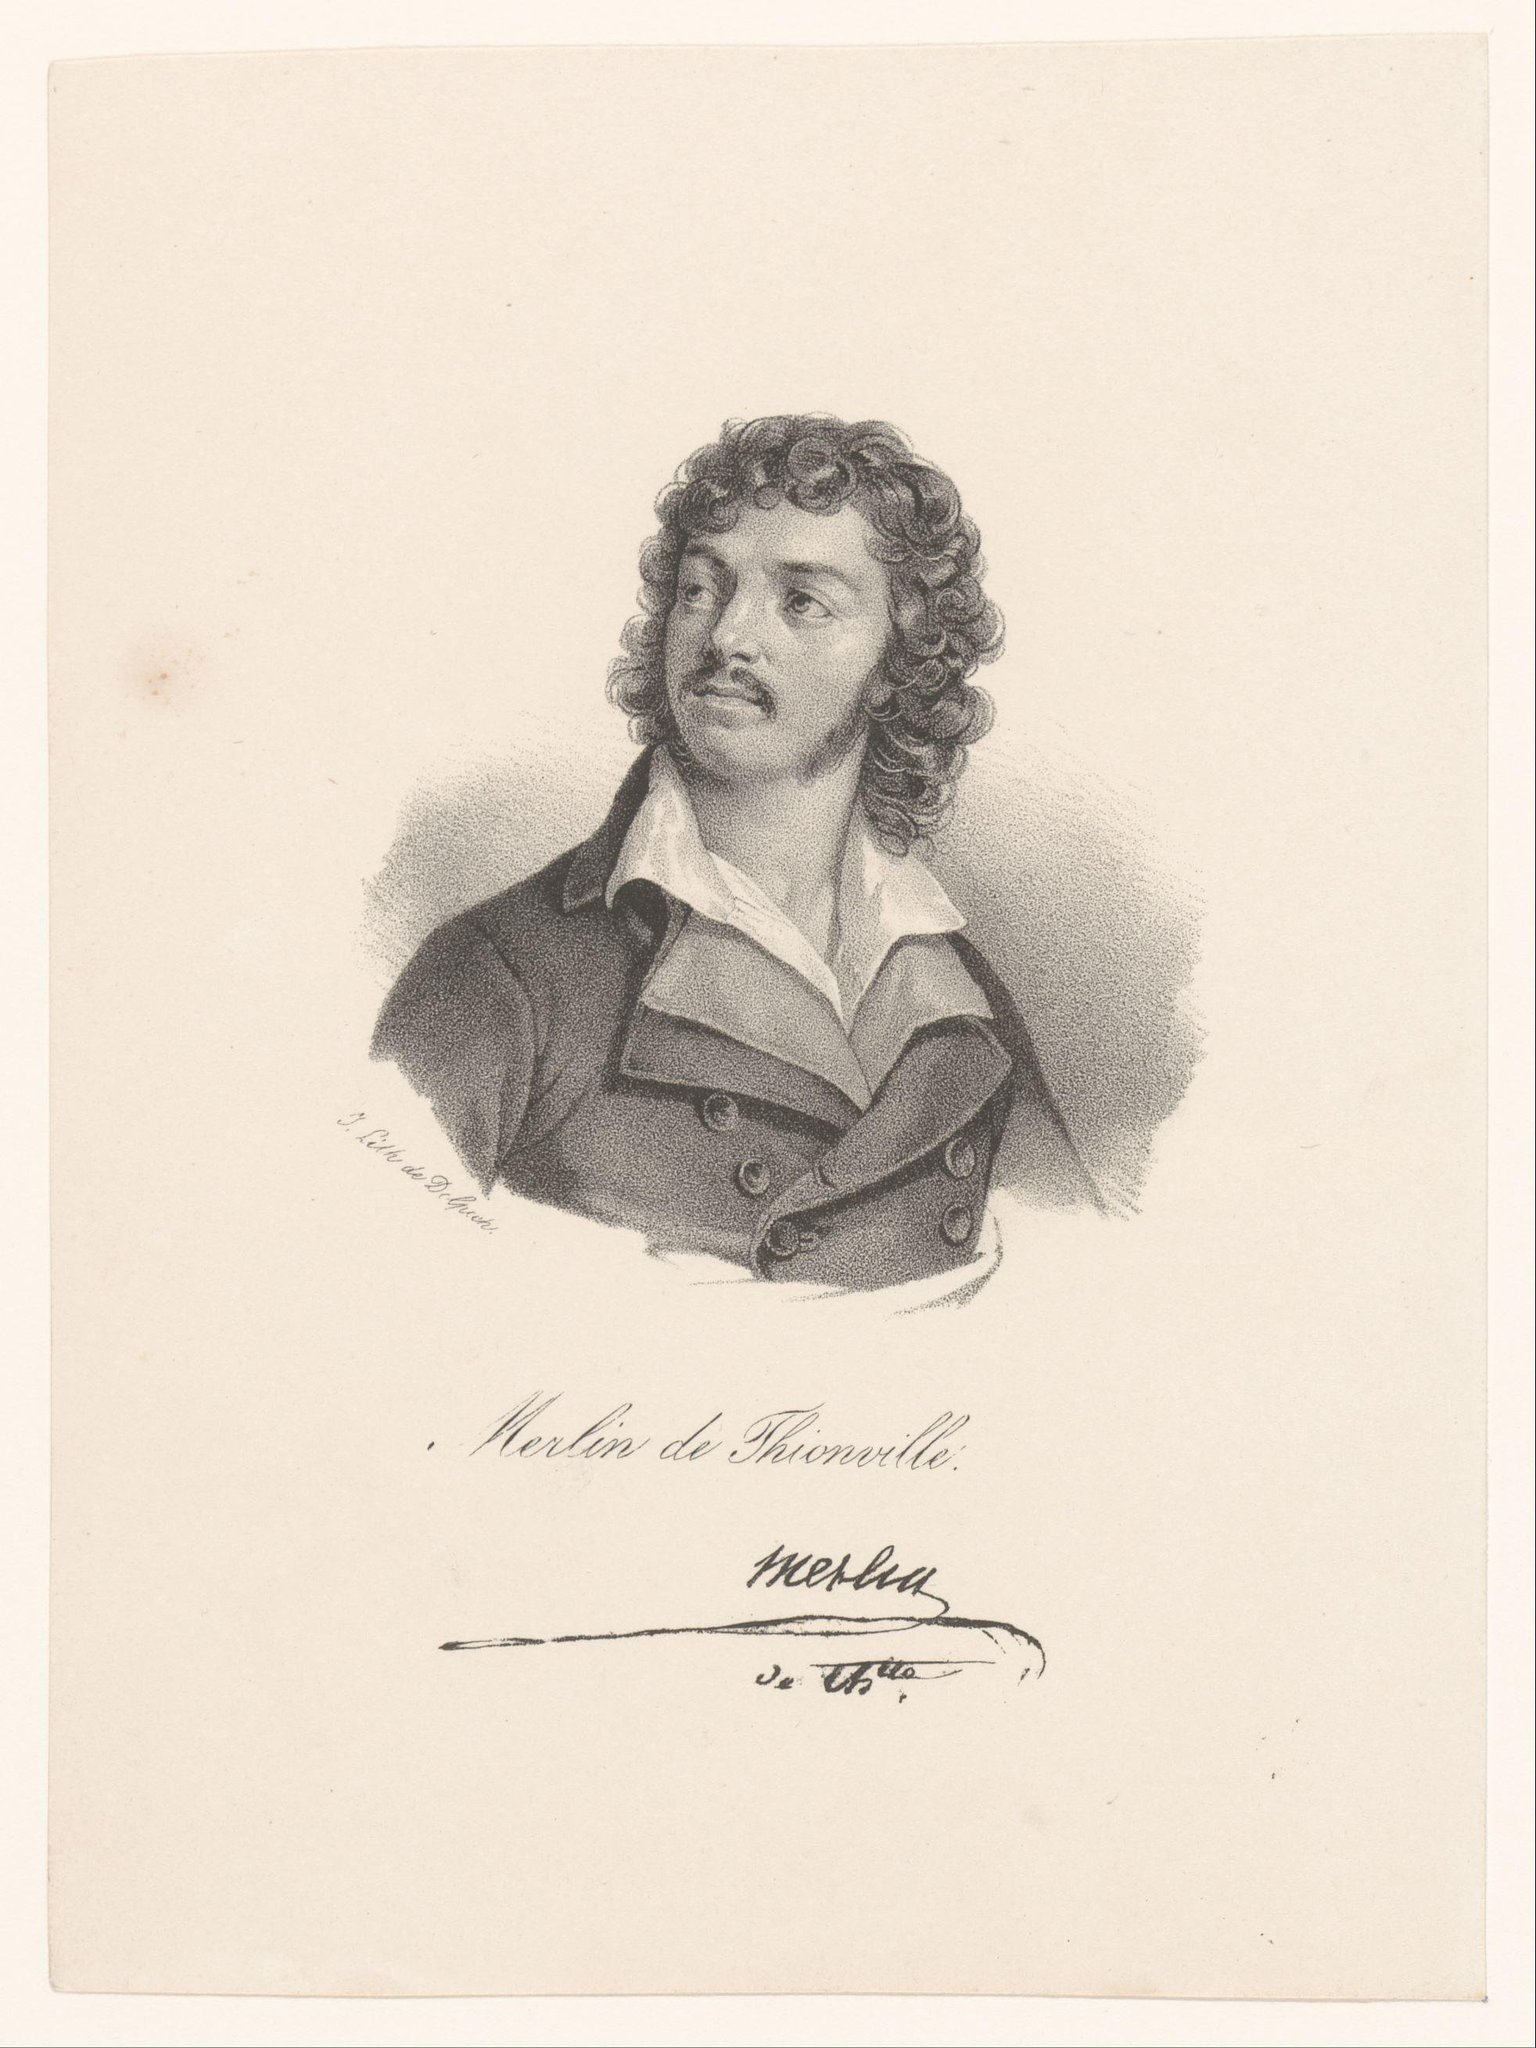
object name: print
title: Merlin de Thionville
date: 1818-1842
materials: paper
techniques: lithograph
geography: paris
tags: paris, politician, historical persons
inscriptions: collector's mark: Lugt 2228a